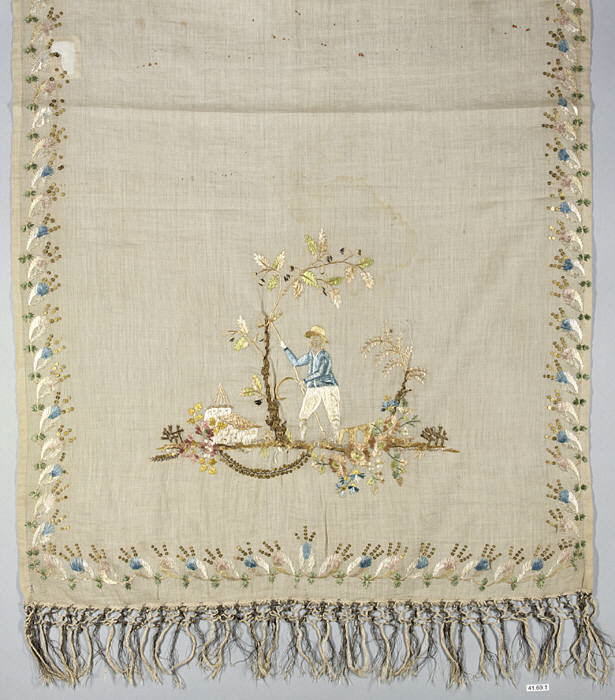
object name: scarf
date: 1801-1900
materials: cotton, metal thread, silk